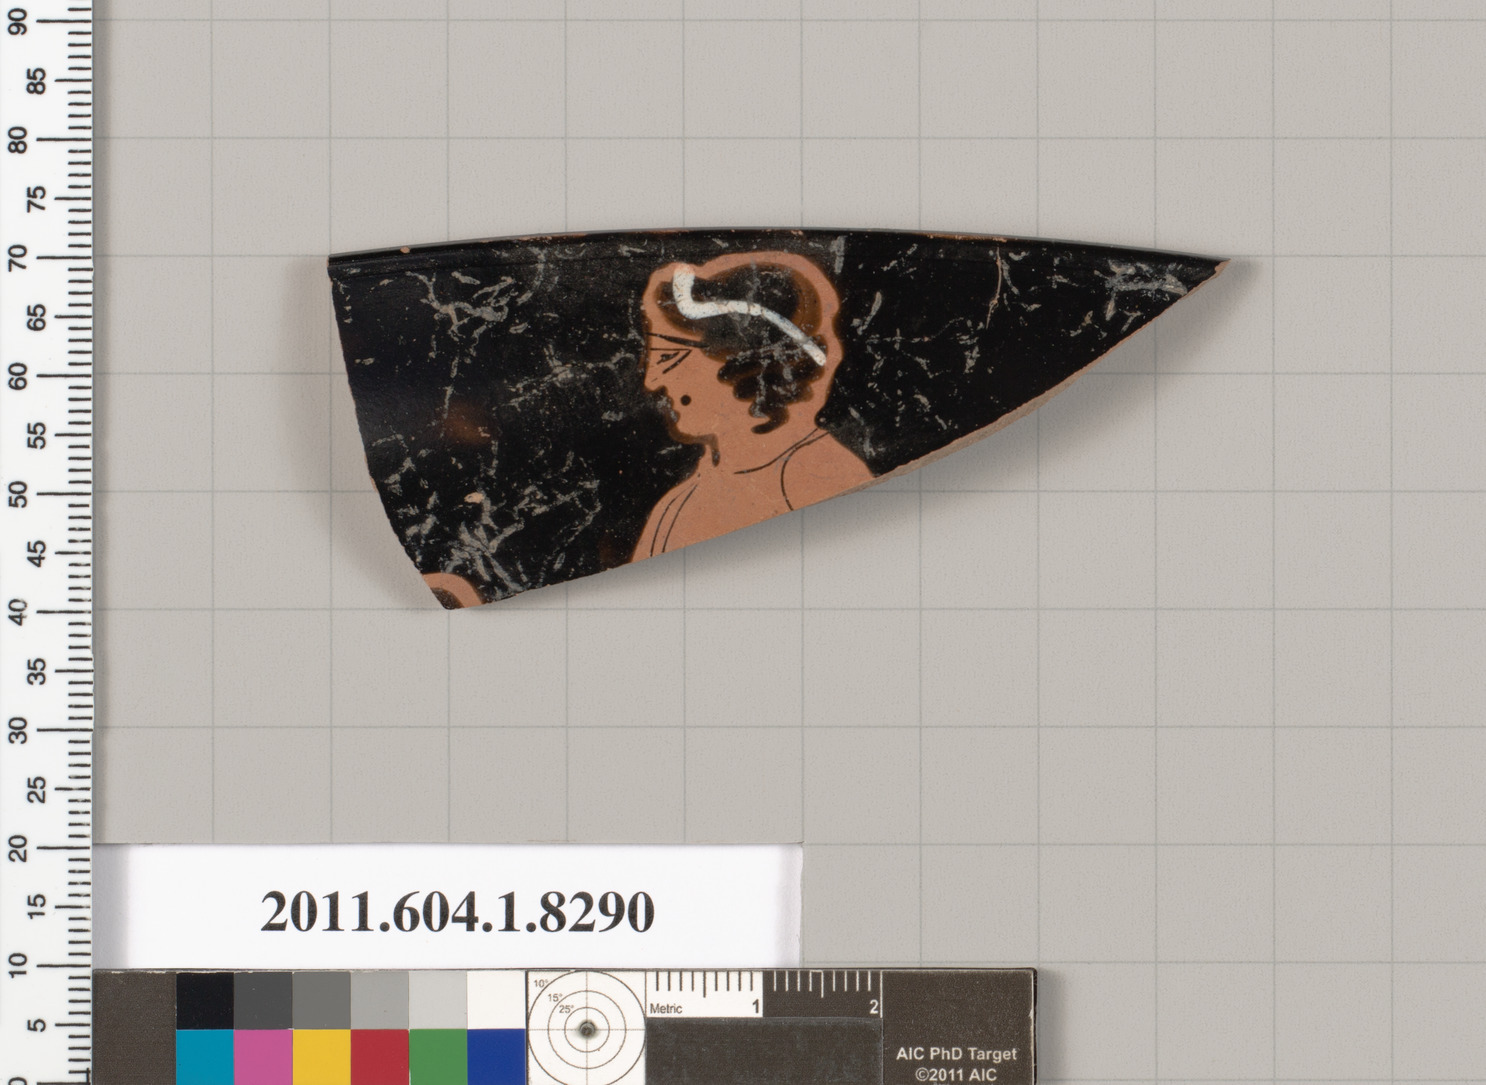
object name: kylix fragment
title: Terracotta rim fragment of a kylix (drinking cup)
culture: greek, attic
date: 400-376 BCE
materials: terracotta